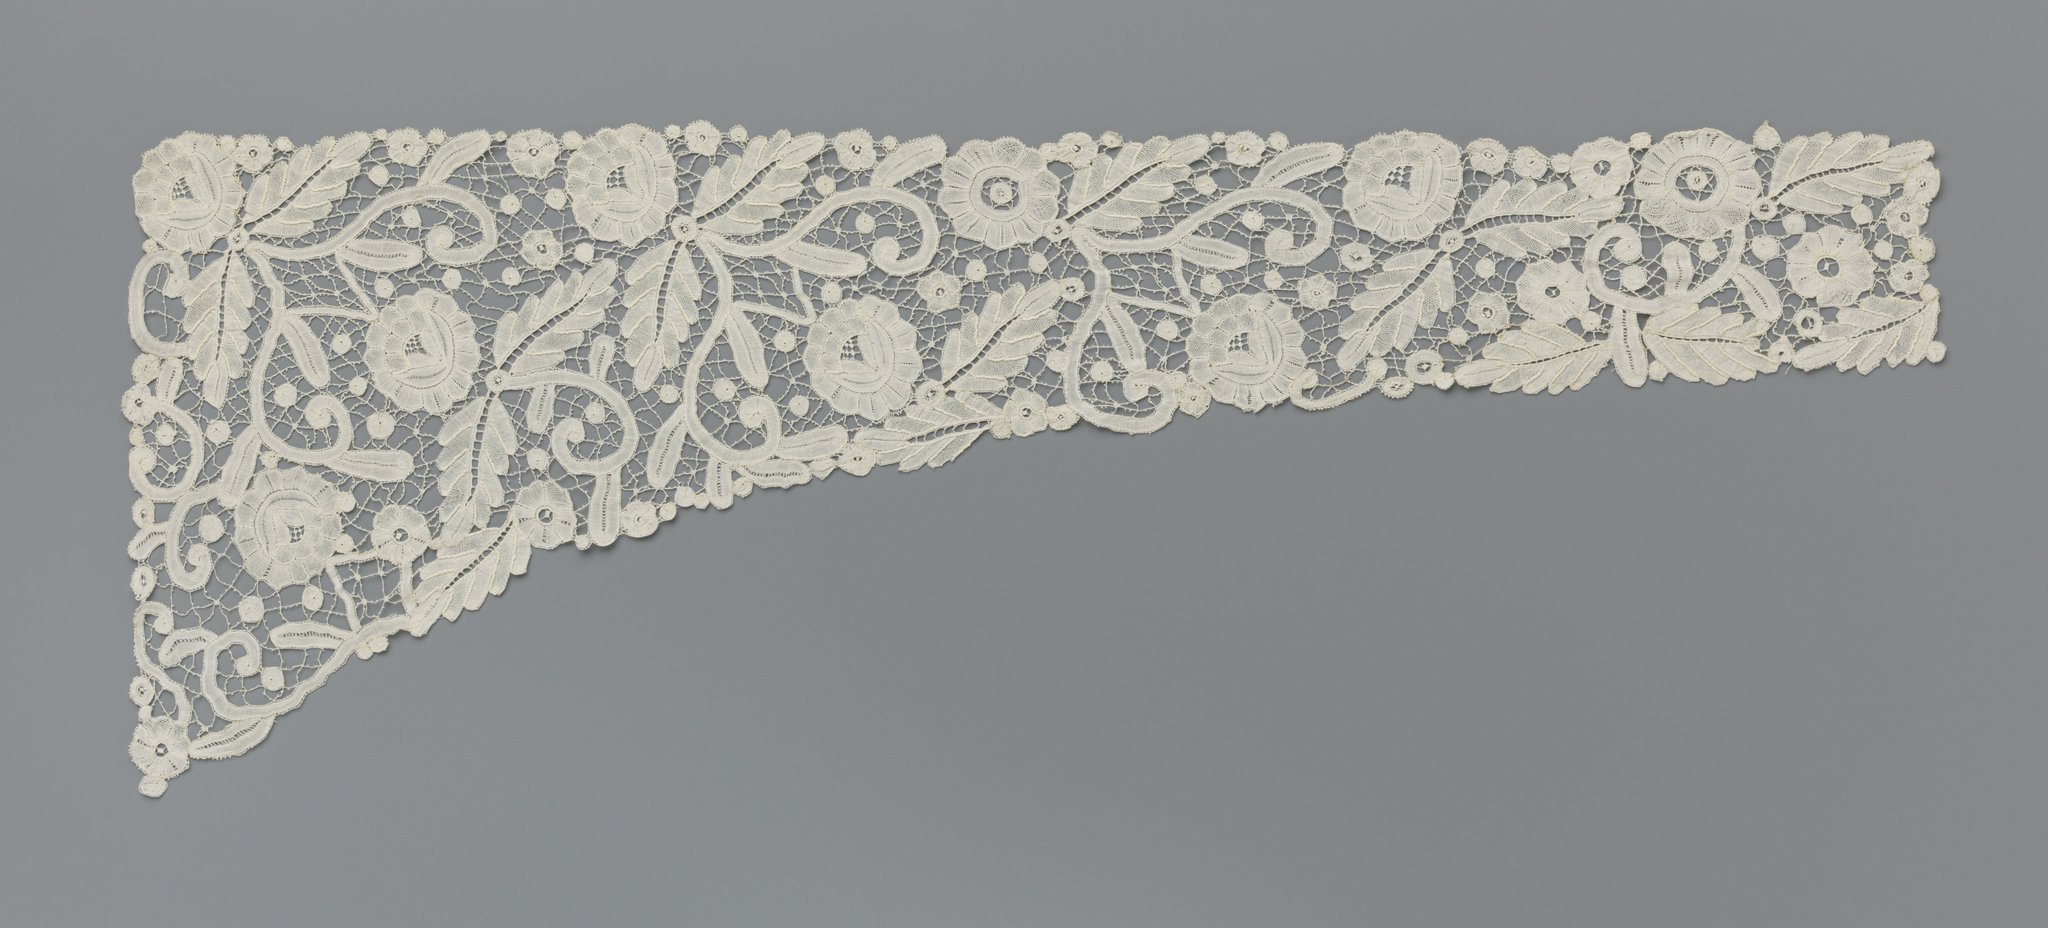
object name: sierstuk, sierobject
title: Sierstuk voor een avondmantel van gemengde kant met rozenhaag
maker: martha berkers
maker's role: kantwerkster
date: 1915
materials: linen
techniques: lace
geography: sluis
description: Sierstuk voor een avondmantel van naturelkleurige gemengde kant - kloskant in combinatie met naaldkant - Brusselse duchesse. Op een wijd gespreide vlechtengrond staan rozen die meestal op twee bladeren steunen. Een tussenornament bestaat uit enkele en dubbele voluutranken en vele kleine bloempjes.